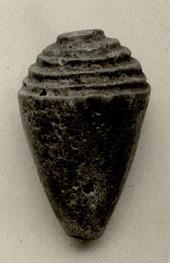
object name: model shell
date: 1981-1640 BCE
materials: faience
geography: egypt